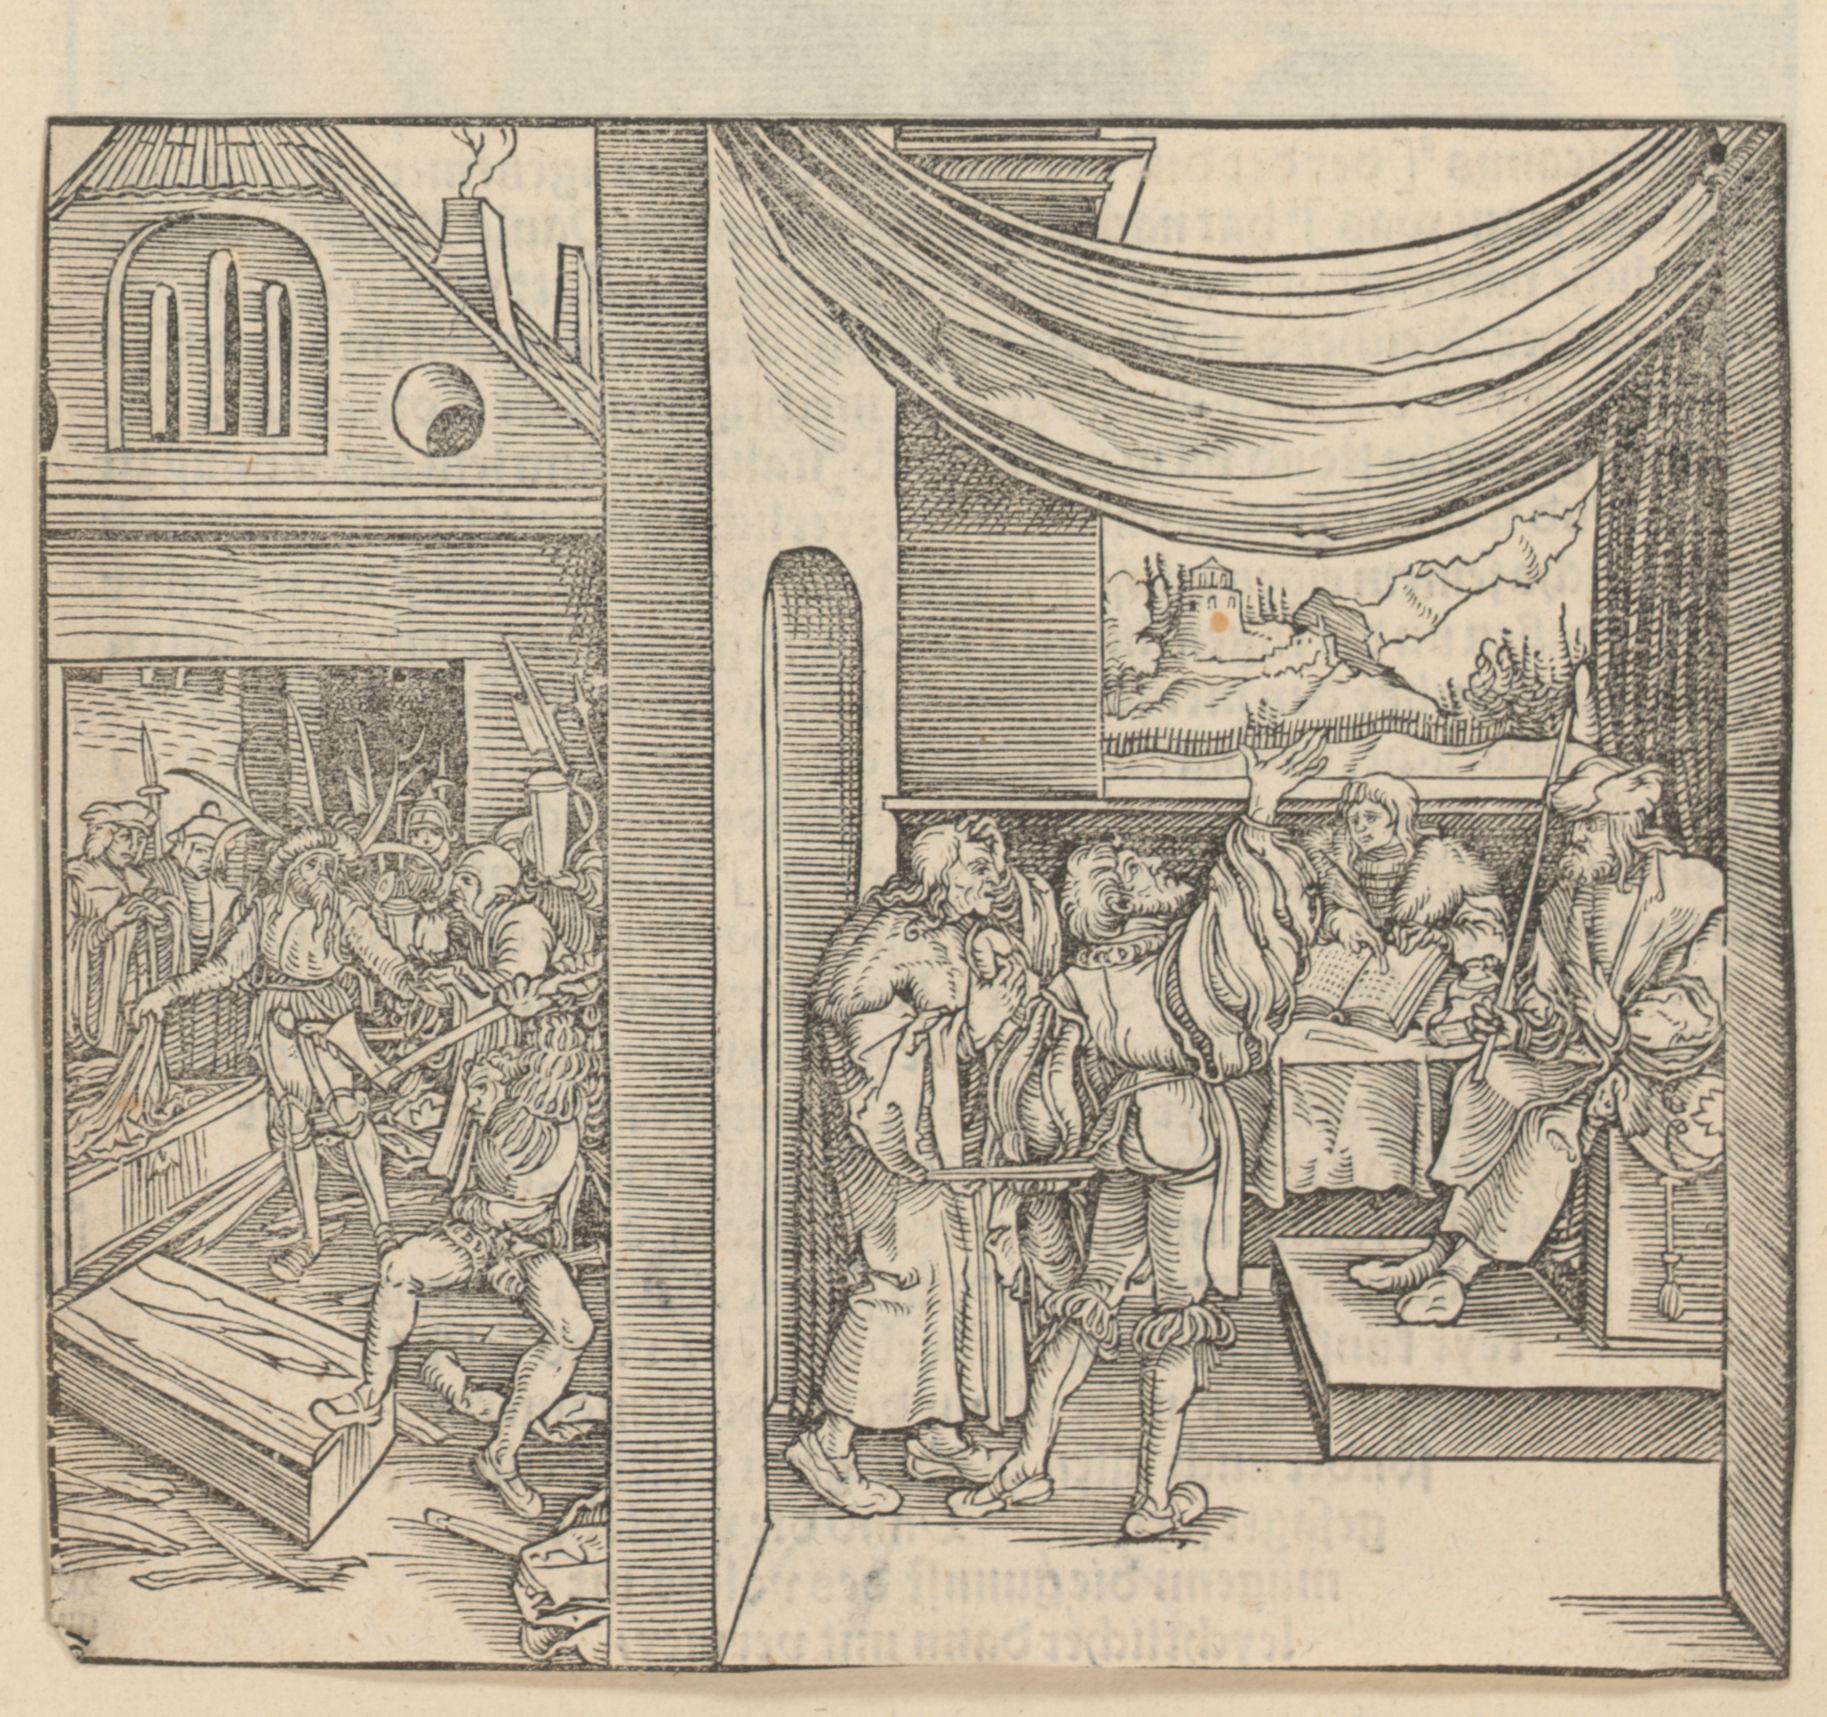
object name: print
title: Rechtszaak en verdeling van geroofde goederen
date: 1514-1531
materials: paper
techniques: letterpress printing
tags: administration of justice, trial, division of the spoils of war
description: Deze prent is gebruikt in: Cicero, Marcus Tulius. Officia M.T.C. Ein Buch so Marcus Tullius Cicero der Römer zu seynem (...). [Vertaald uit het Latijn door] Johann von Schwarzenberg. Augsburg: Heinrich Steiner, 1531.